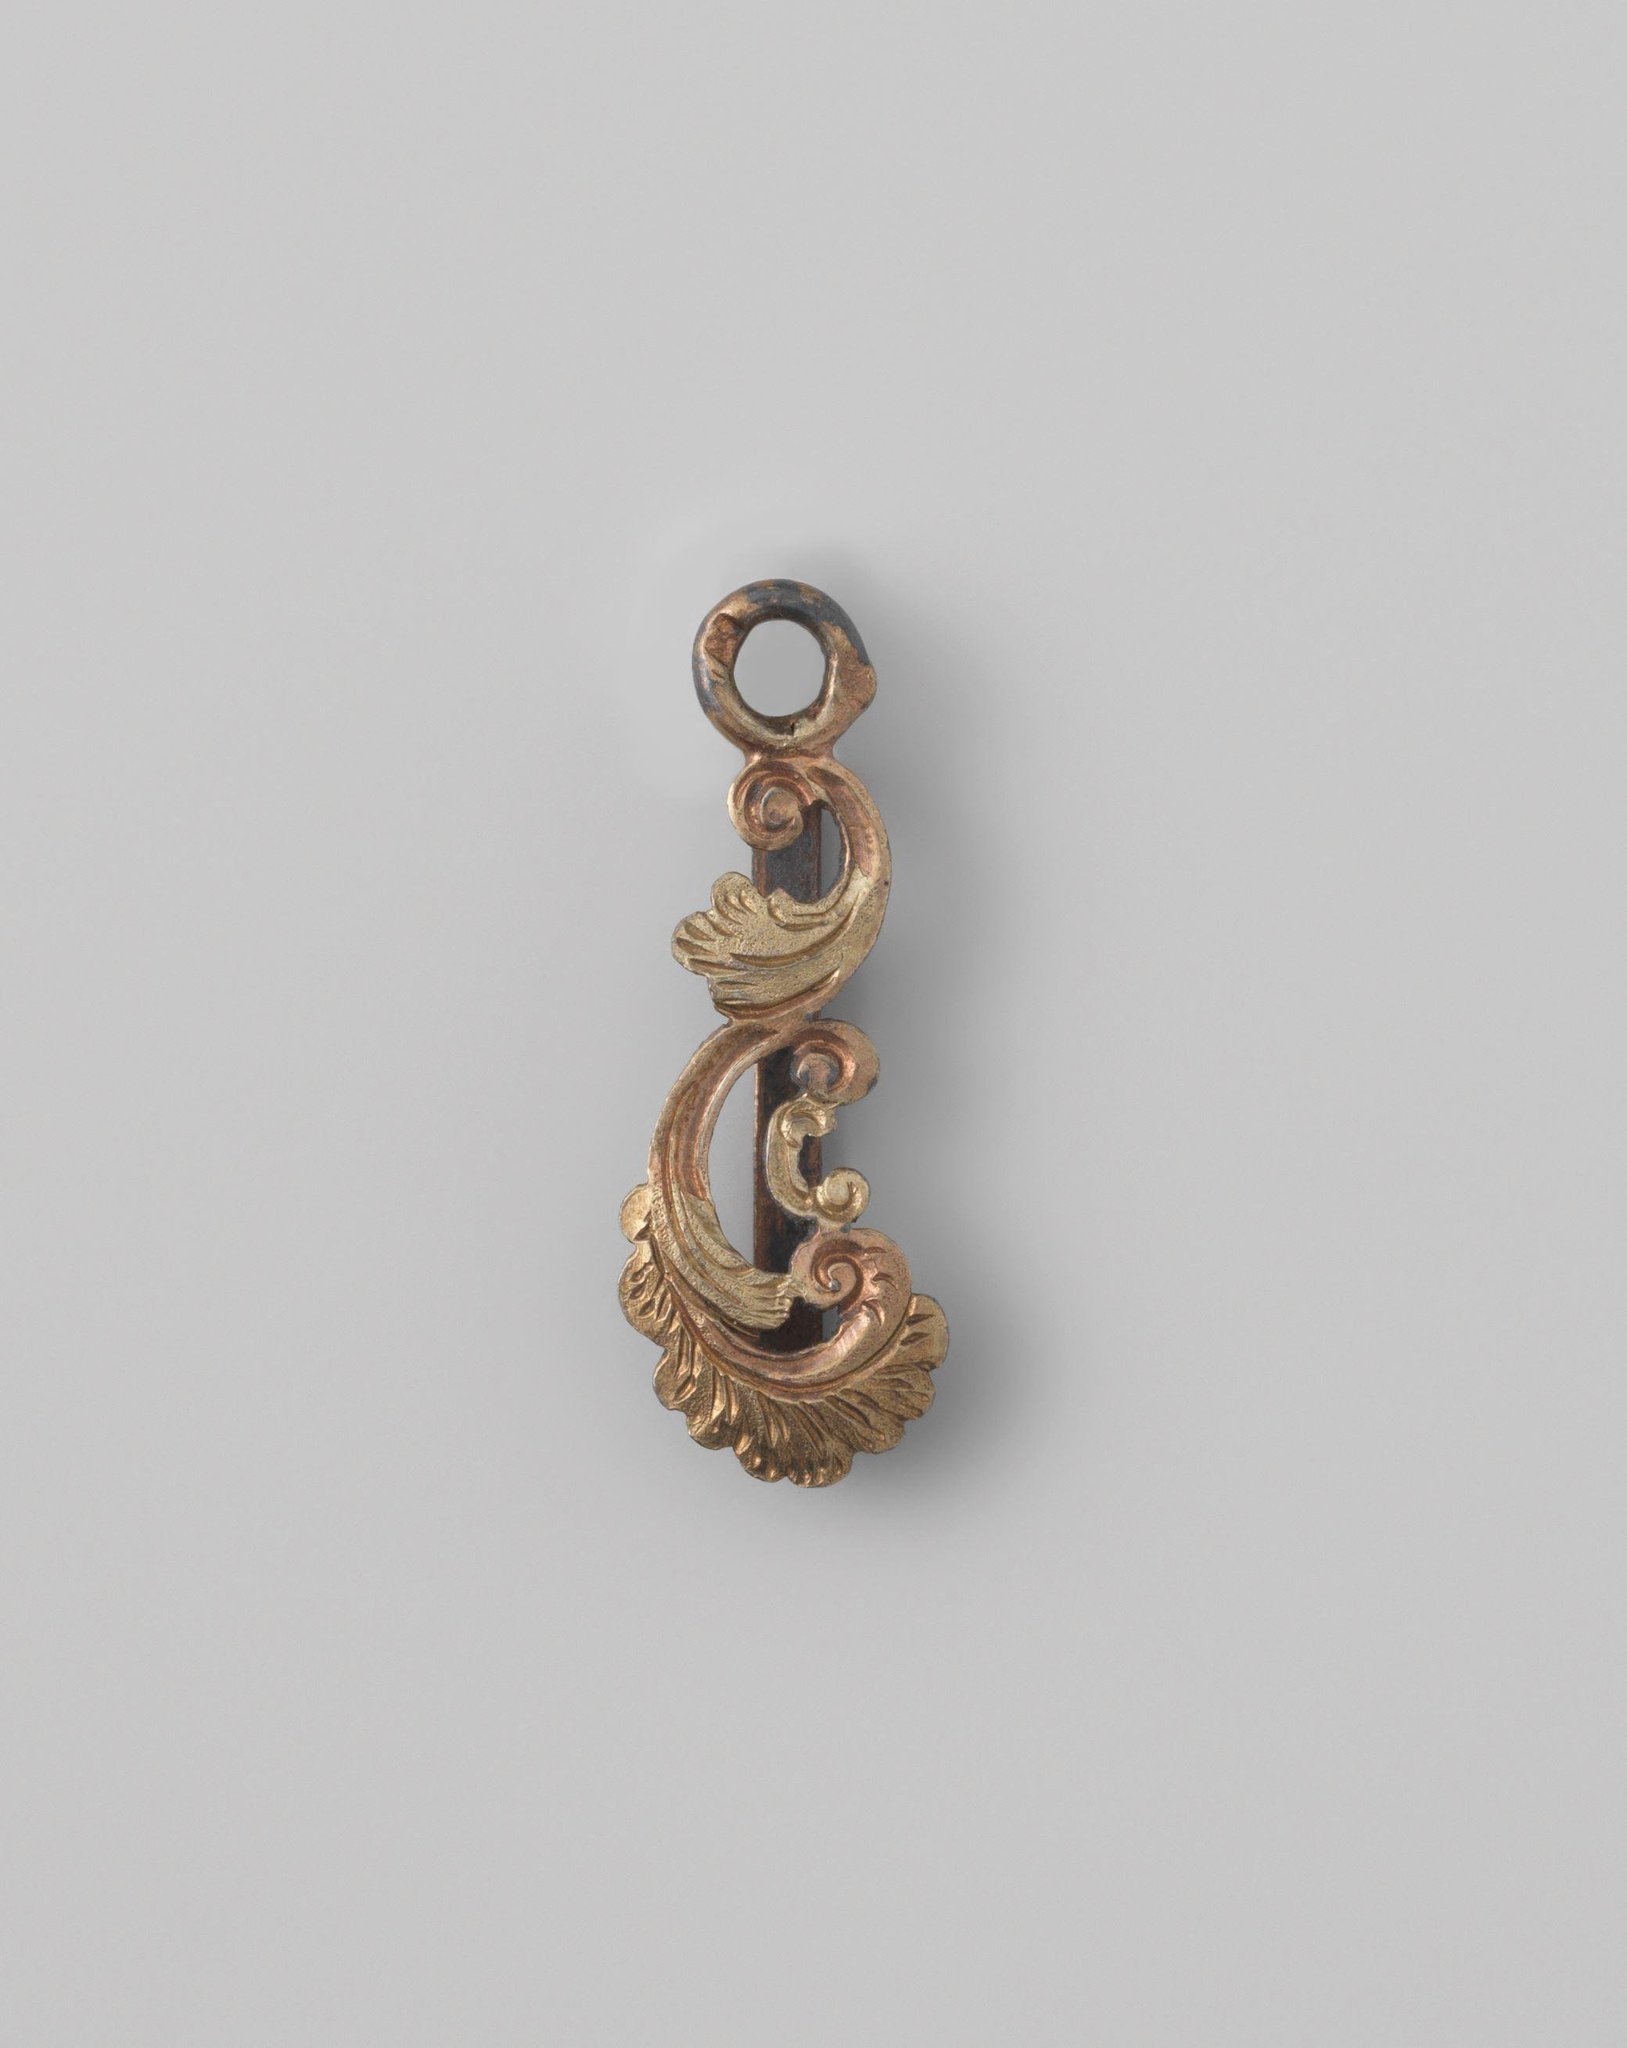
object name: jewellery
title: Schuif met oog, mogelijk voor een halsfluweel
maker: Anonymous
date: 1850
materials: gold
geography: netherlands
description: Schuifje in twee kleuren goud. Het heeft de vorm van een S-voluut met blaadjes; breed bovenaan en zich versmallend naar het oogje toe. Achterop zit een lang, smal schuifje. Mogelijk voor een halsfluweeltje.